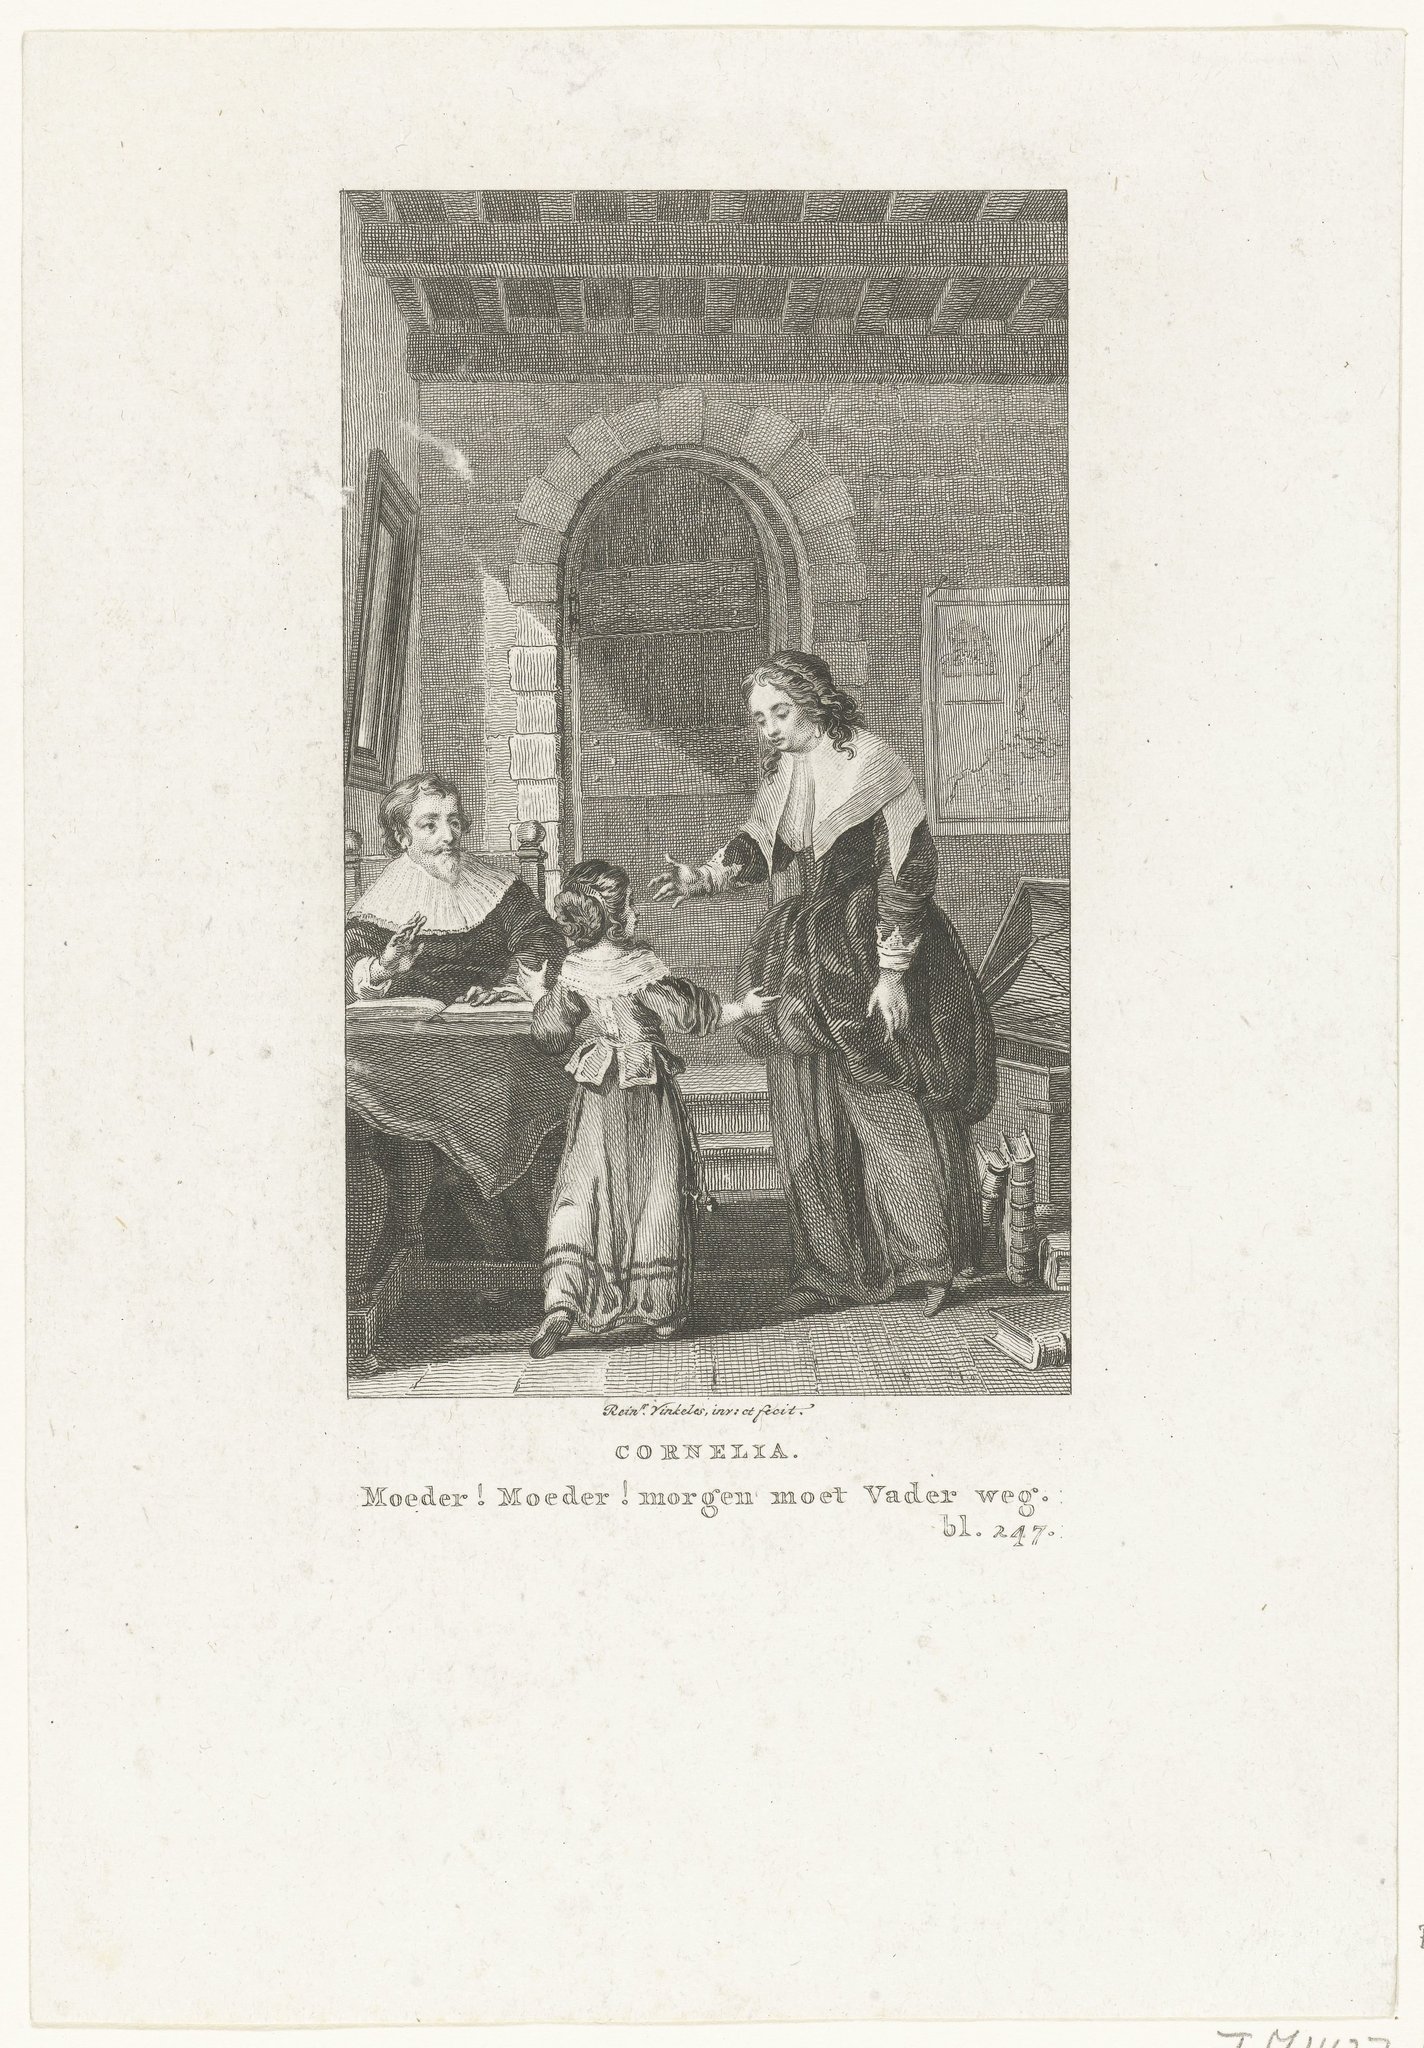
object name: history print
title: Hugo de Groot met vrouw Maria van Reigersberch en dochter Cornelia te Loevestein, 1621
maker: reinier vinkeles (i)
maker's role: draughtsman, print maker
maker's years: 1741-1816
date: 1792-1794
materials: paper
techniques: etching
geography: northern netherlands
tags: delft, hugo de groot, the hague, law and jurisprudence (+ escape from prison), loevestein castle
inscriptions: collector's mark: Lugt 240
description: Hugo de Groot met zijn vrouw Maria van Reigersberch, die het plan voor de ontsnapping met de boekenkist had bedacht, en hun dochter Cornelia te Loevestein, de dag voor de ontsnapping op 22 maart 1621.